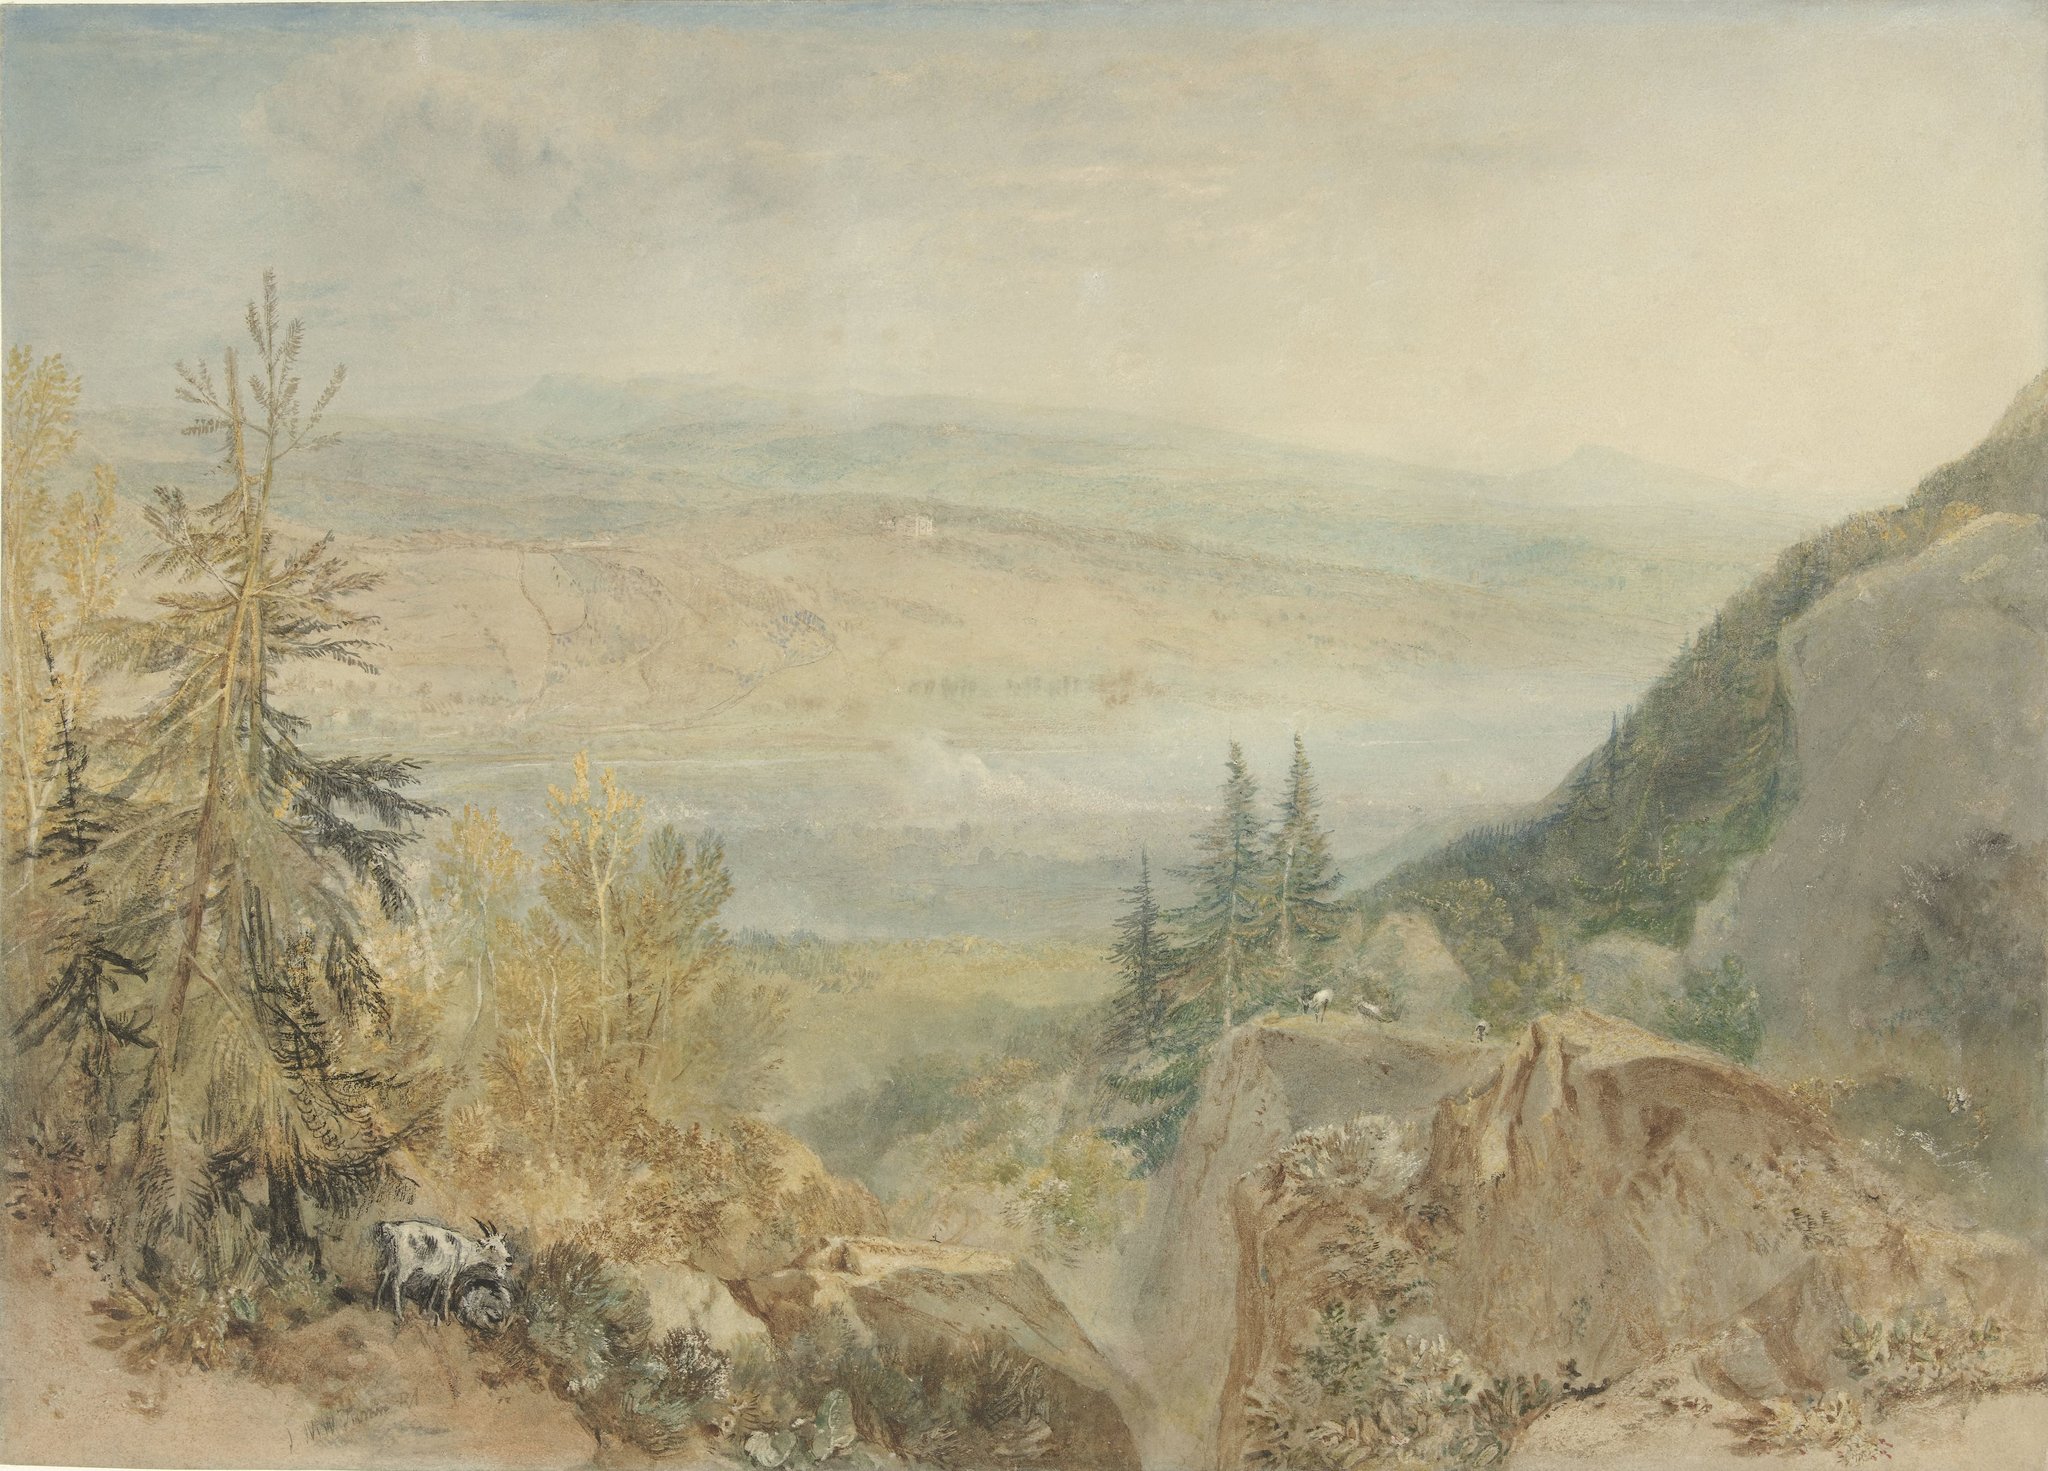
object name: drawing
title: View of Farnley Hall in Yorkshire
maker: joseph mallord william turner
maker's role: draughtsman, print maker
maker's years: 1775-1851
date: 1808-1825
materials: paint, paper, watercolor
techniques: brush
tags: dale, valley, mountains (+ landscape with figures, staffage)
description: The house of Turner’s friend, the collector Walter Fawkes, is depicted in the distance of this watercolour. It is a free interpretation of reality, dominated by atmospheric light effects. Turner did not paint watercolours of this kind out of doors, but based them on drawn studies of nature. In his studio, he would first make a schematic colour sketch of the composition before actually beginning to paint a watercolour.